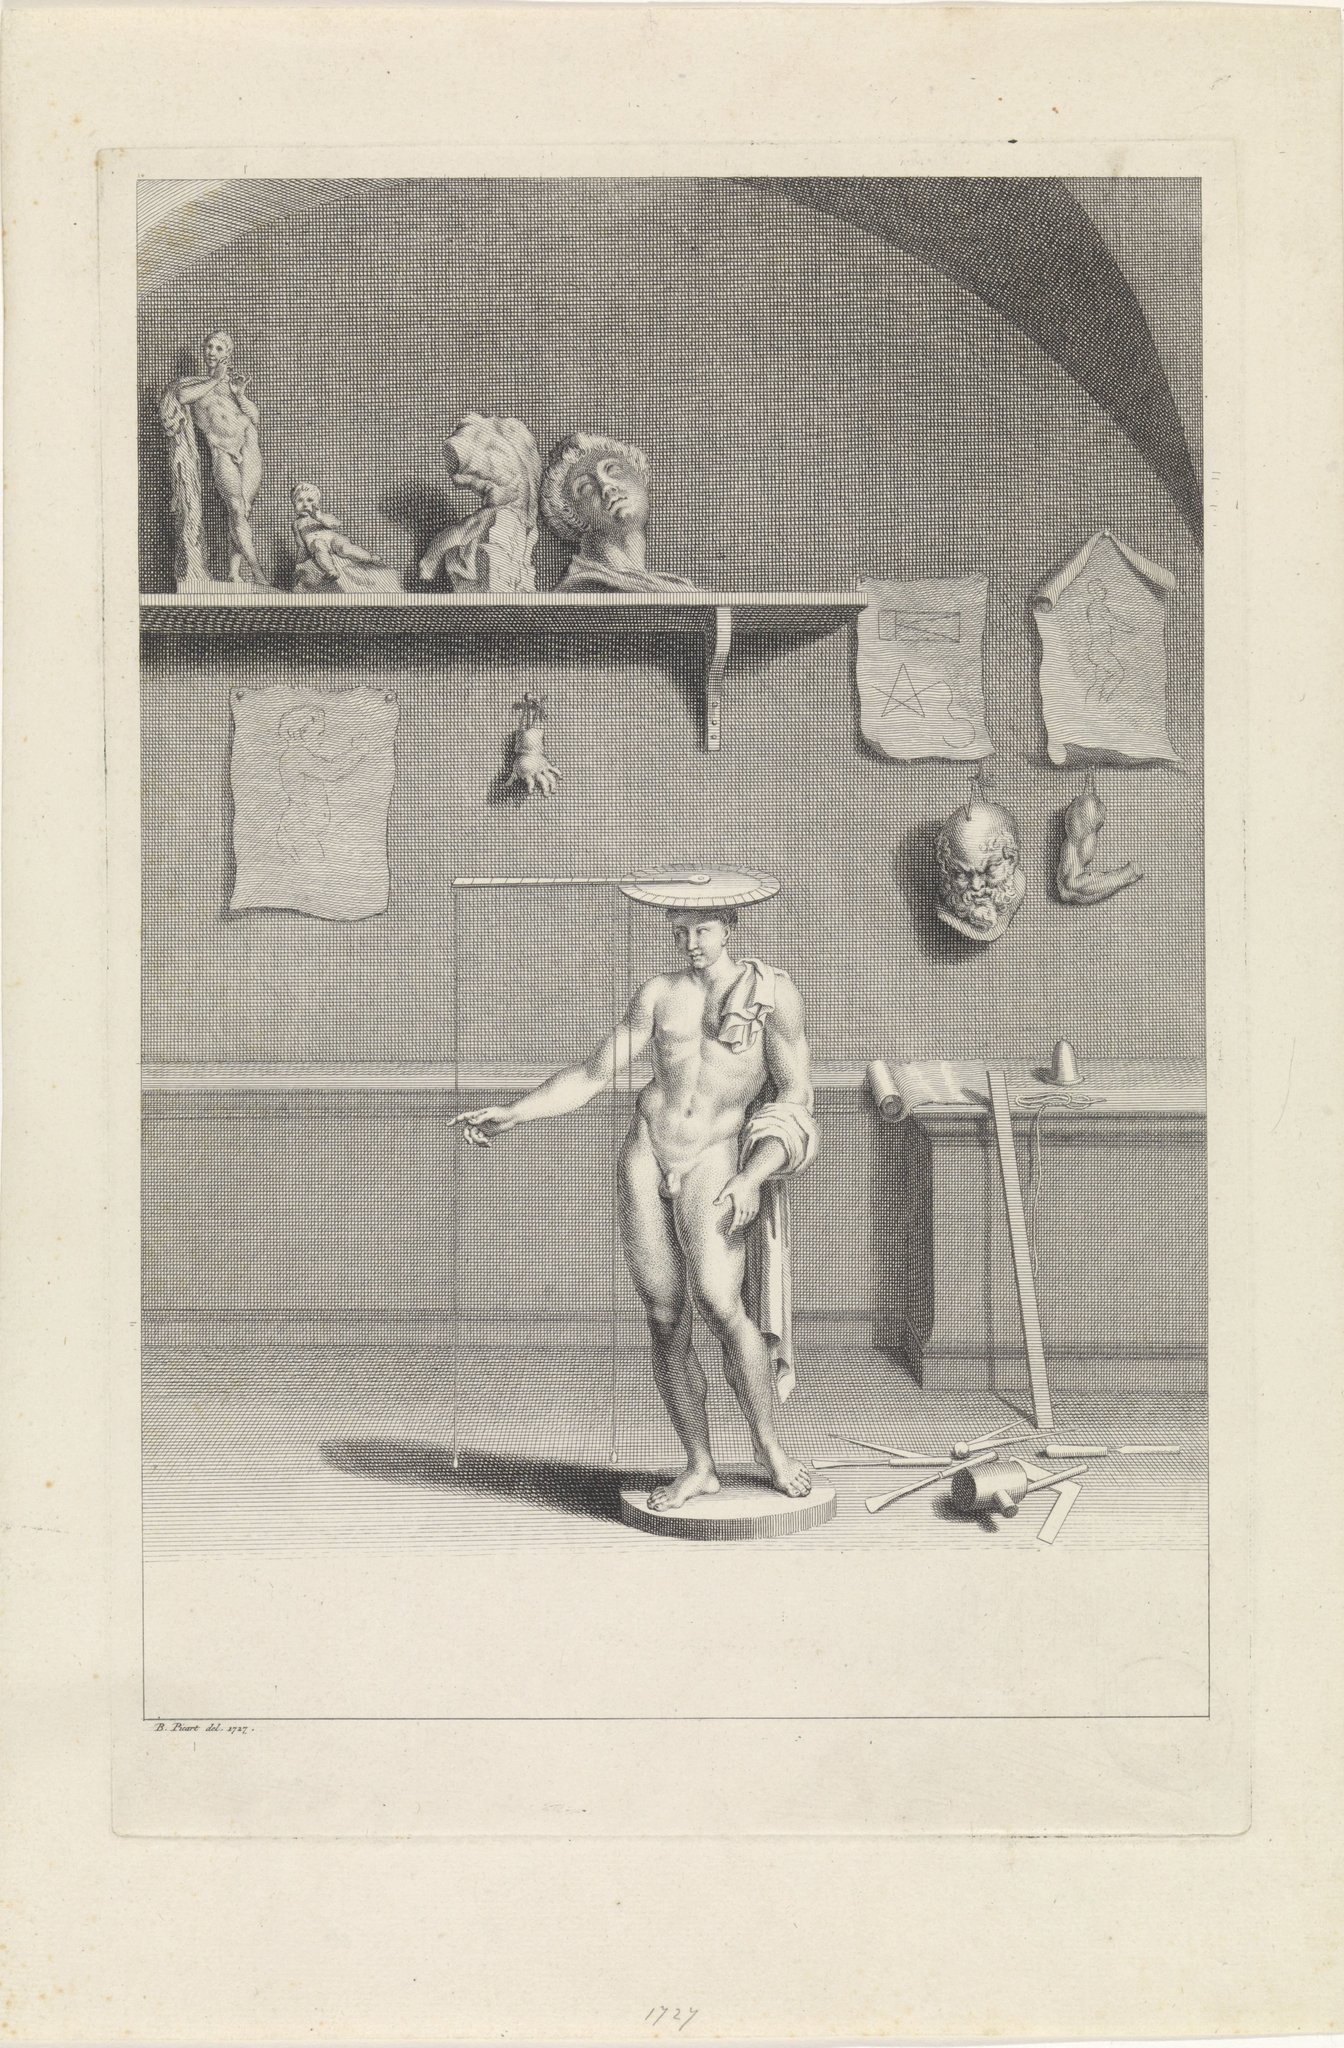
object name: print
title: Manieren om de menselijke figuur te beeldhouwen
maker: bernard picart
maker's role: draughtsman, print maker, publisher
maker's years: 1673-1733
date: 1727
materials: paper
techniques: engraving, etching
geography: amsterdam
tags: piece of sculpture, reproduction of a piece of sculpture, workshop, studio of the artist (in general)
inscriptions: collector's mark: Lugt 240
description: Vertrek waarin allerlei benodigdheden voor de kunst van het beeldhouwen. Op de voorgrond een standbeeld en meetinstrumenten en beitels op de vloer. Aan de muur tekenvoorbeelden en kleine sculpturen.